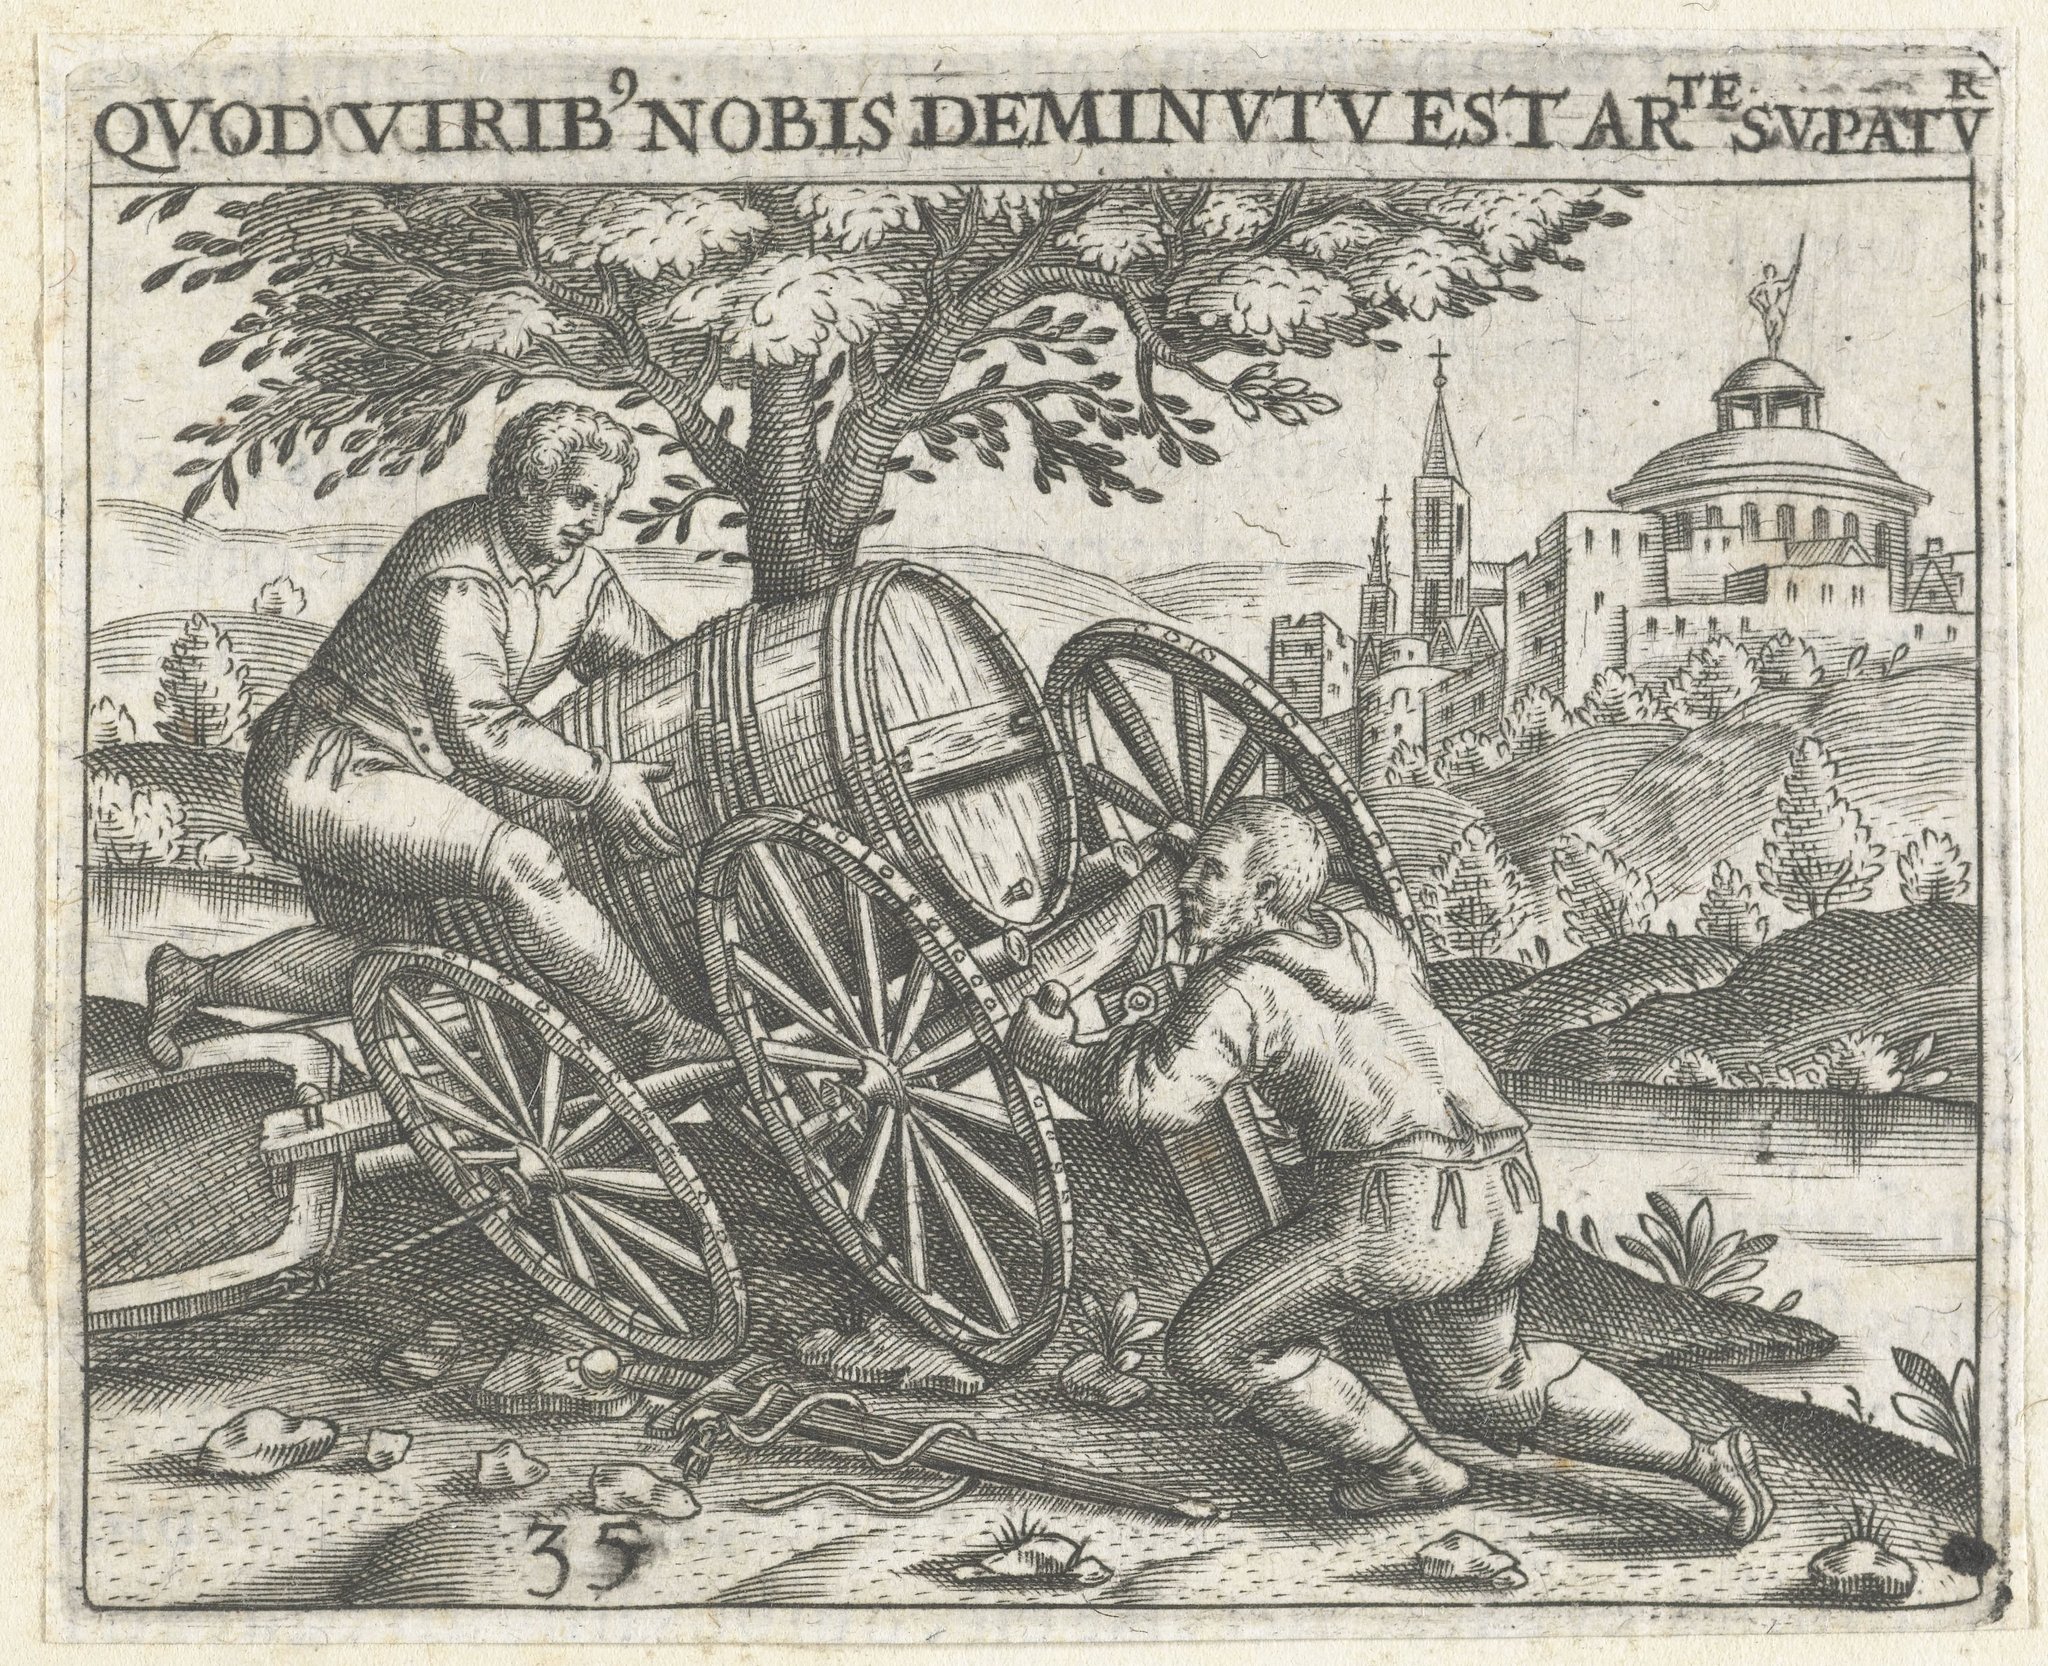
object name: print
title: Denis Lebey de Batilly, Emblemata, 1596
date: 1596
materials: paper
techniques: engraving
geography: frankfurt am main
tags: accident with (farm) wagon, freight wagon, cart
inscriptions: collector's mark: Lugt 240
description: Een kar met een wijnvat staat op een stenige weg met pech. Twee mannen proberen om de kar weer op de weg te krijgen.